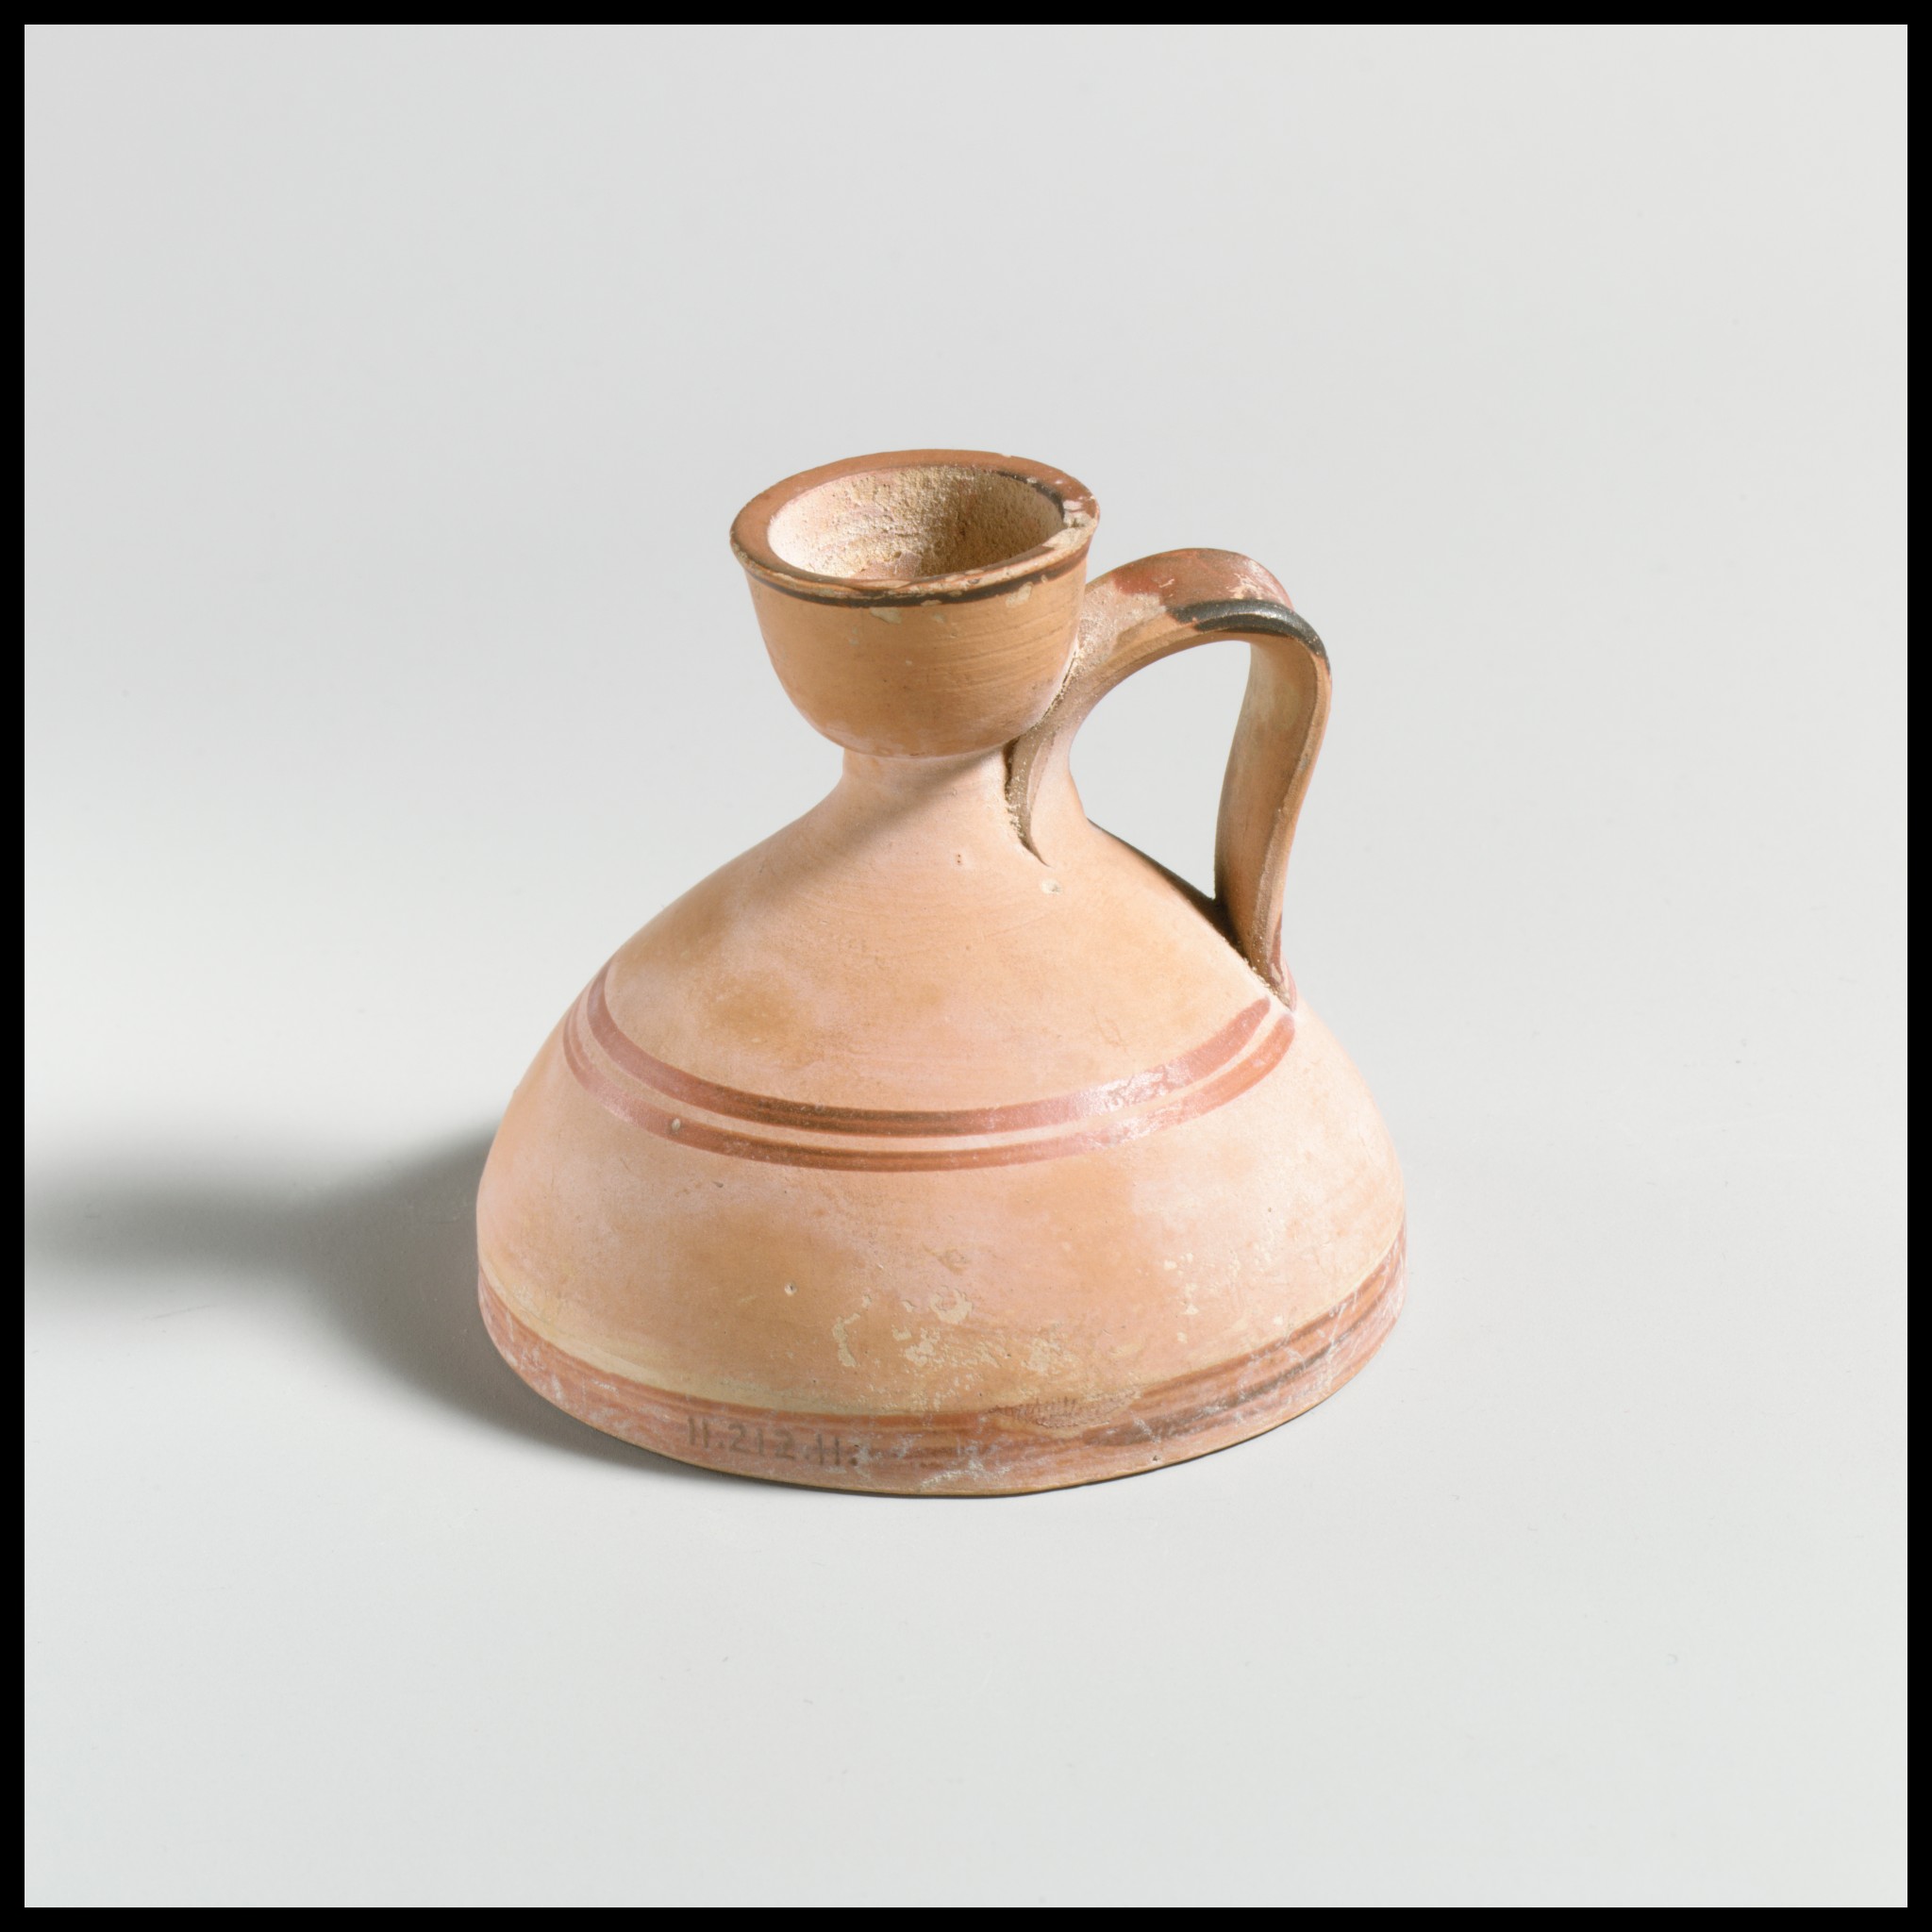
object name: lekythos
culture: greek or south italian or campanian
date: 434-401 BCE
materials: terracotta